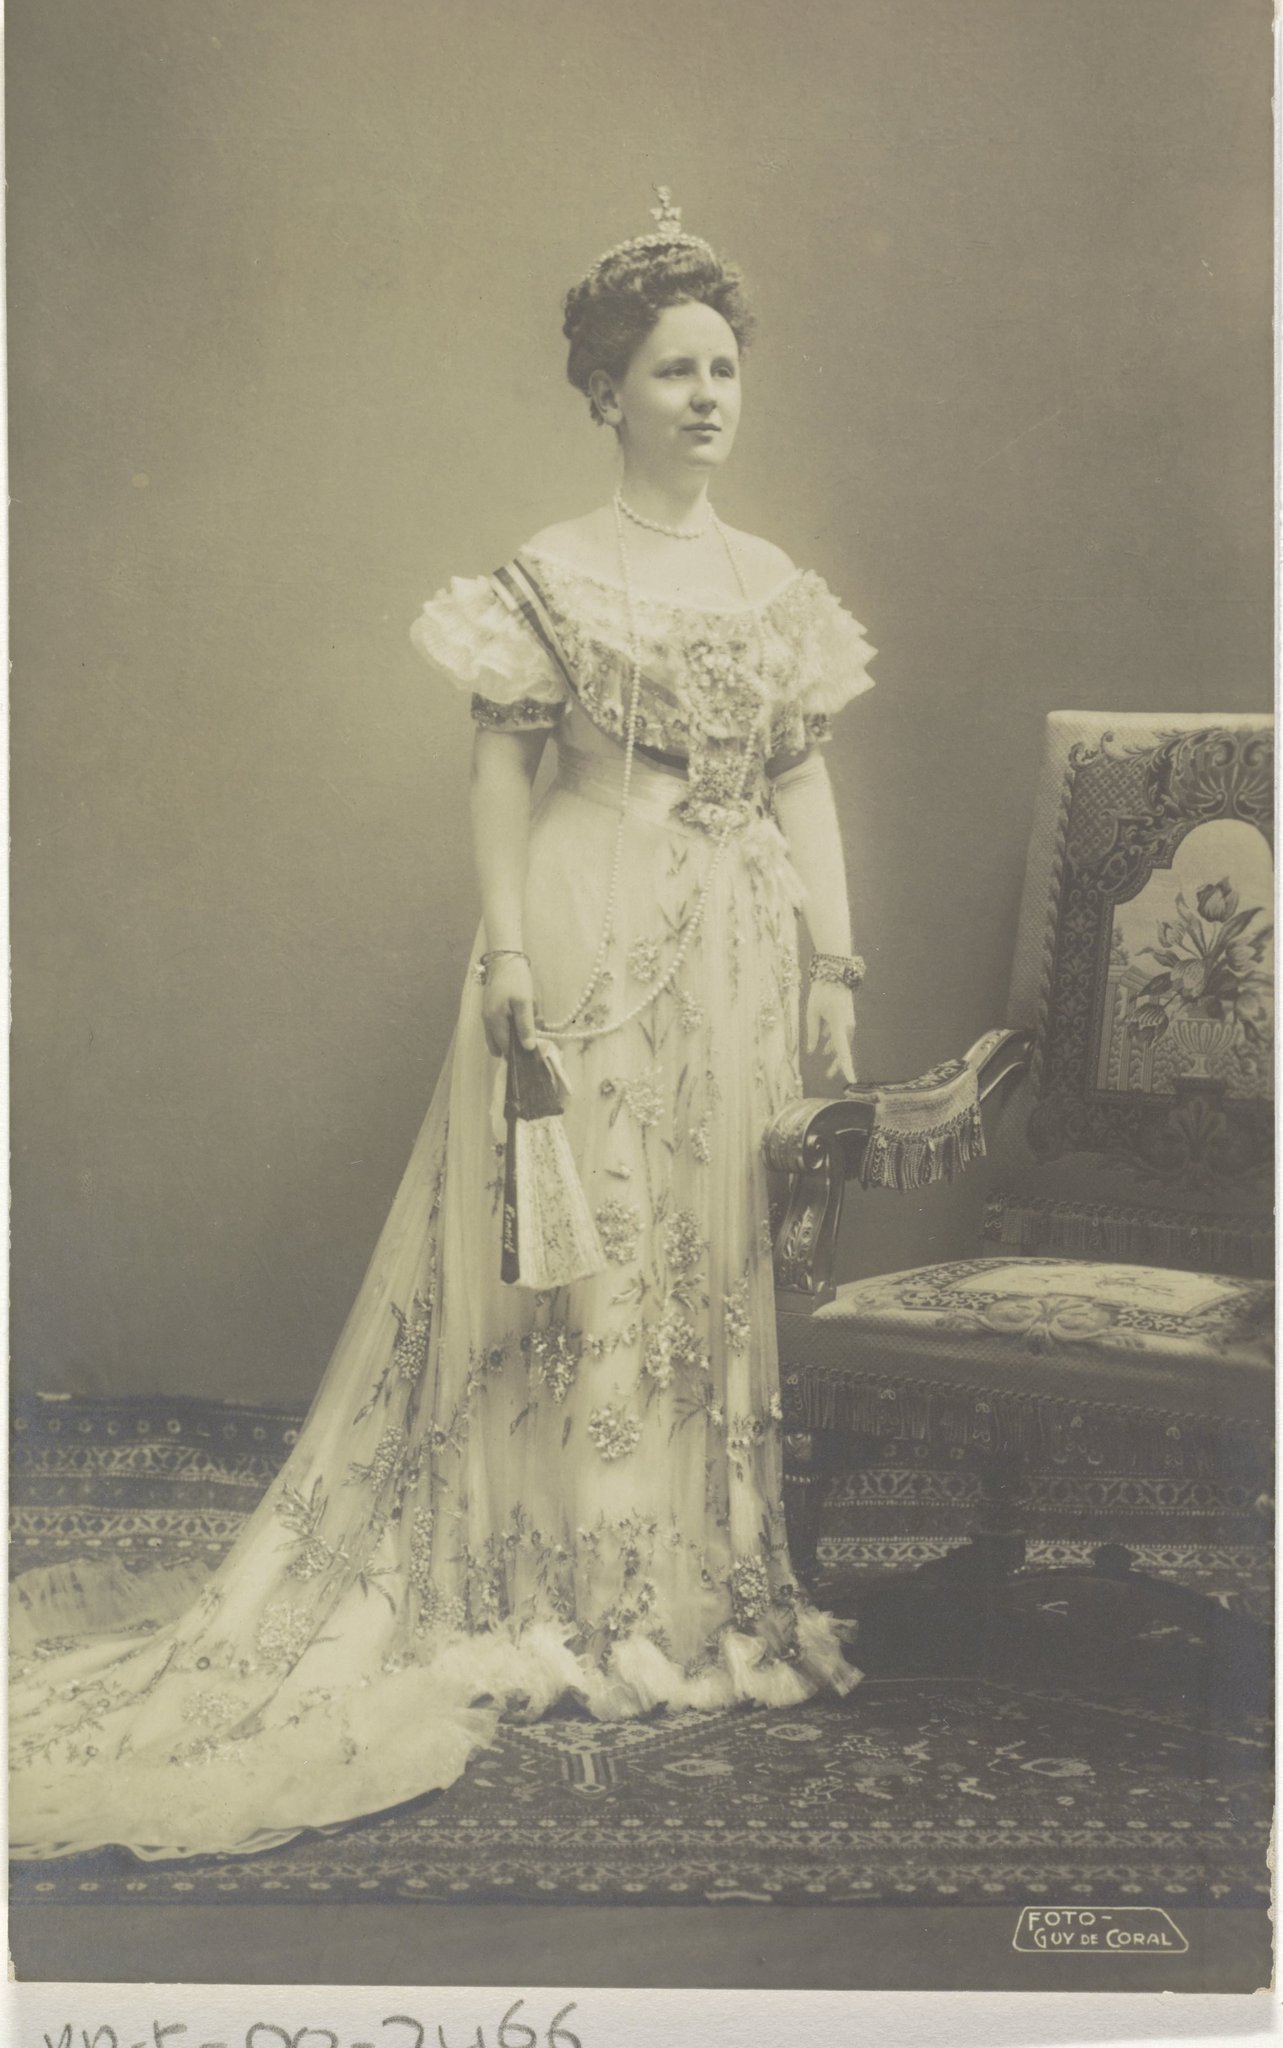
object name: ansichtkaart, prentbriefkaart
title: Portret van Wilhelmina, koningin der Nederlanden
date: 1905-1910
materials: photographic support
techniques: photography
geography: netherlands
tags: wilhelmina of the netherlands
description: De hier vermelde titel verwijst naar de hoogst verkregen titel van de geportretteerde, niet per se naar de titel die de geportretteerde op deze voorstelling draagt.